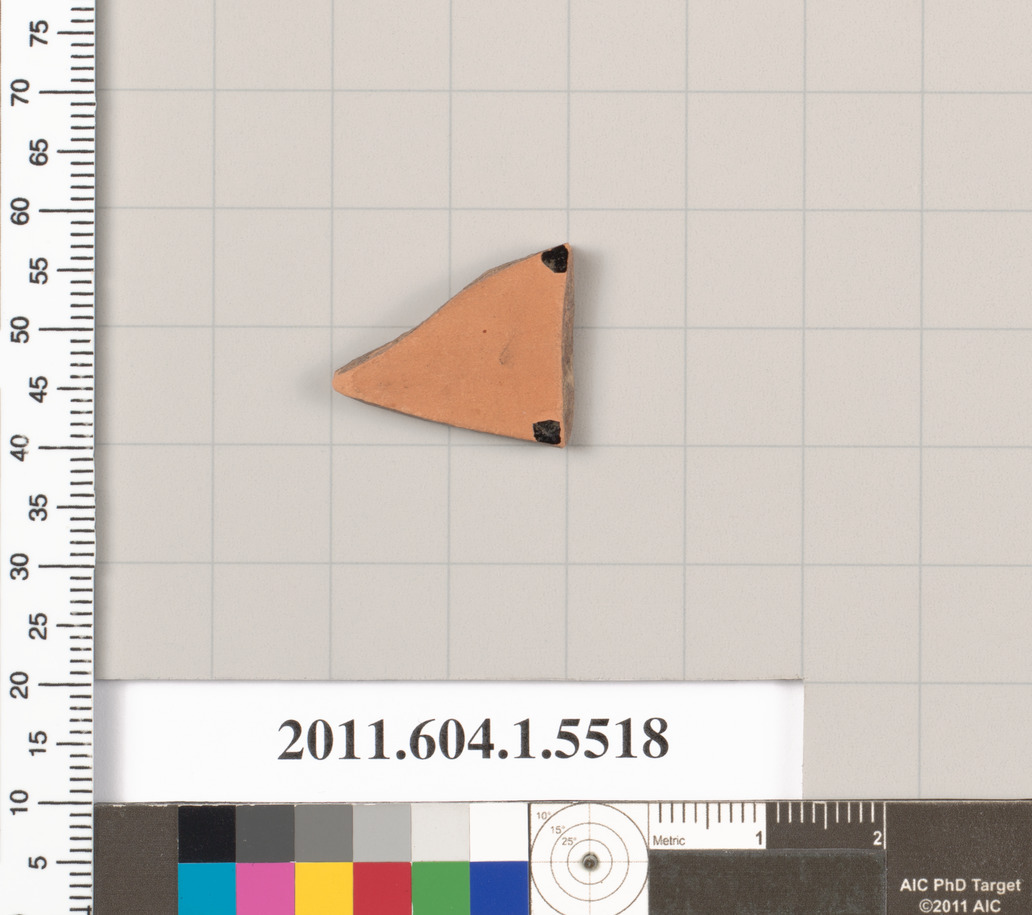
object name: kylix fragment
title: Terracotta fragment of a kylix (drinking cup)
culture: greek, attic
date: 510-490 BCE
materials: terracotta